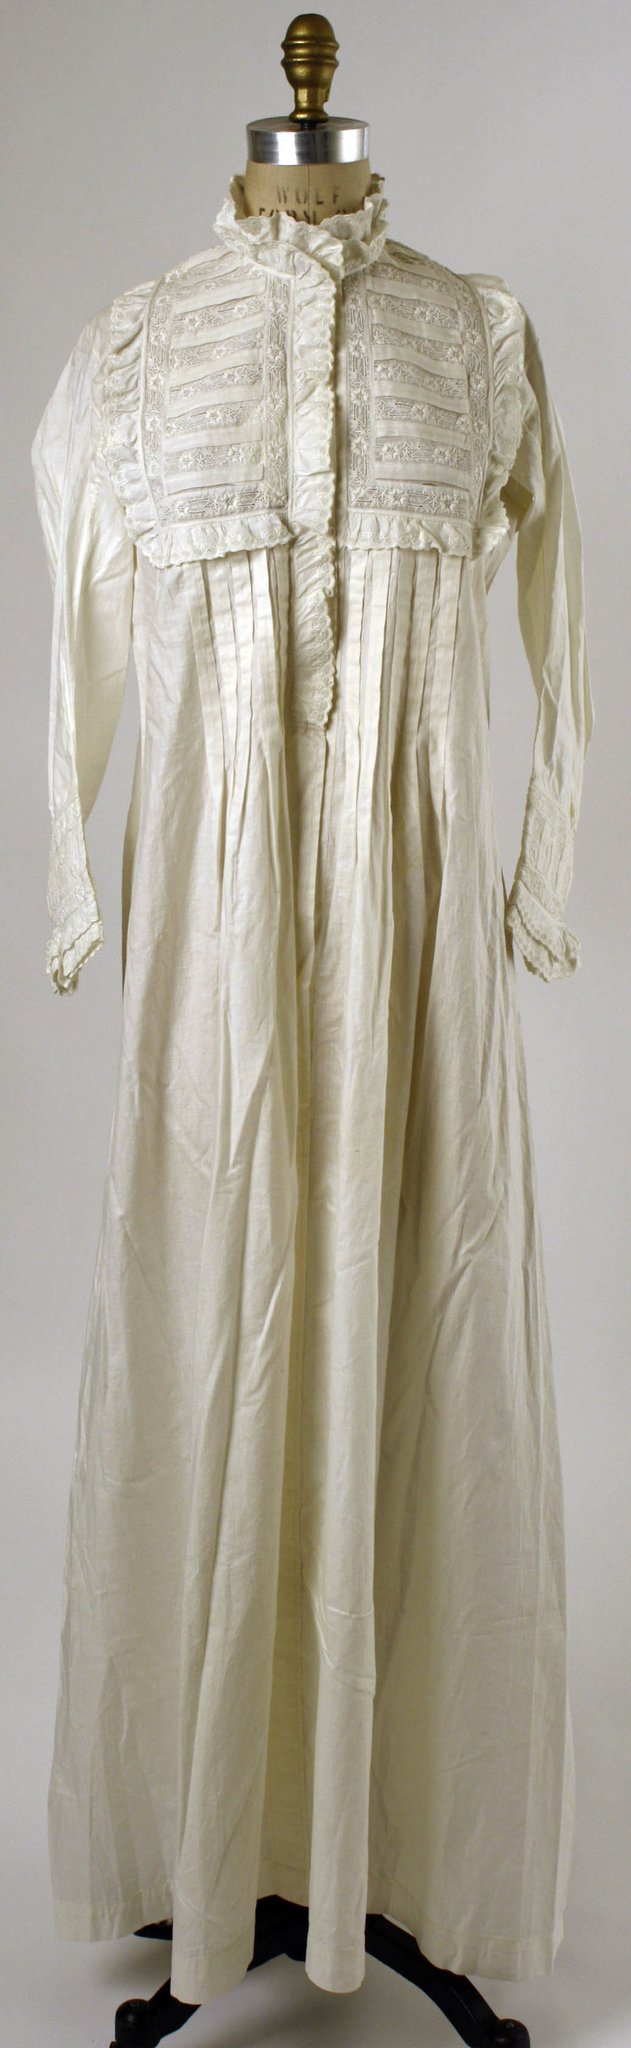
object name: nightgown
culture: american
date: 1880-1889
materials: cotton